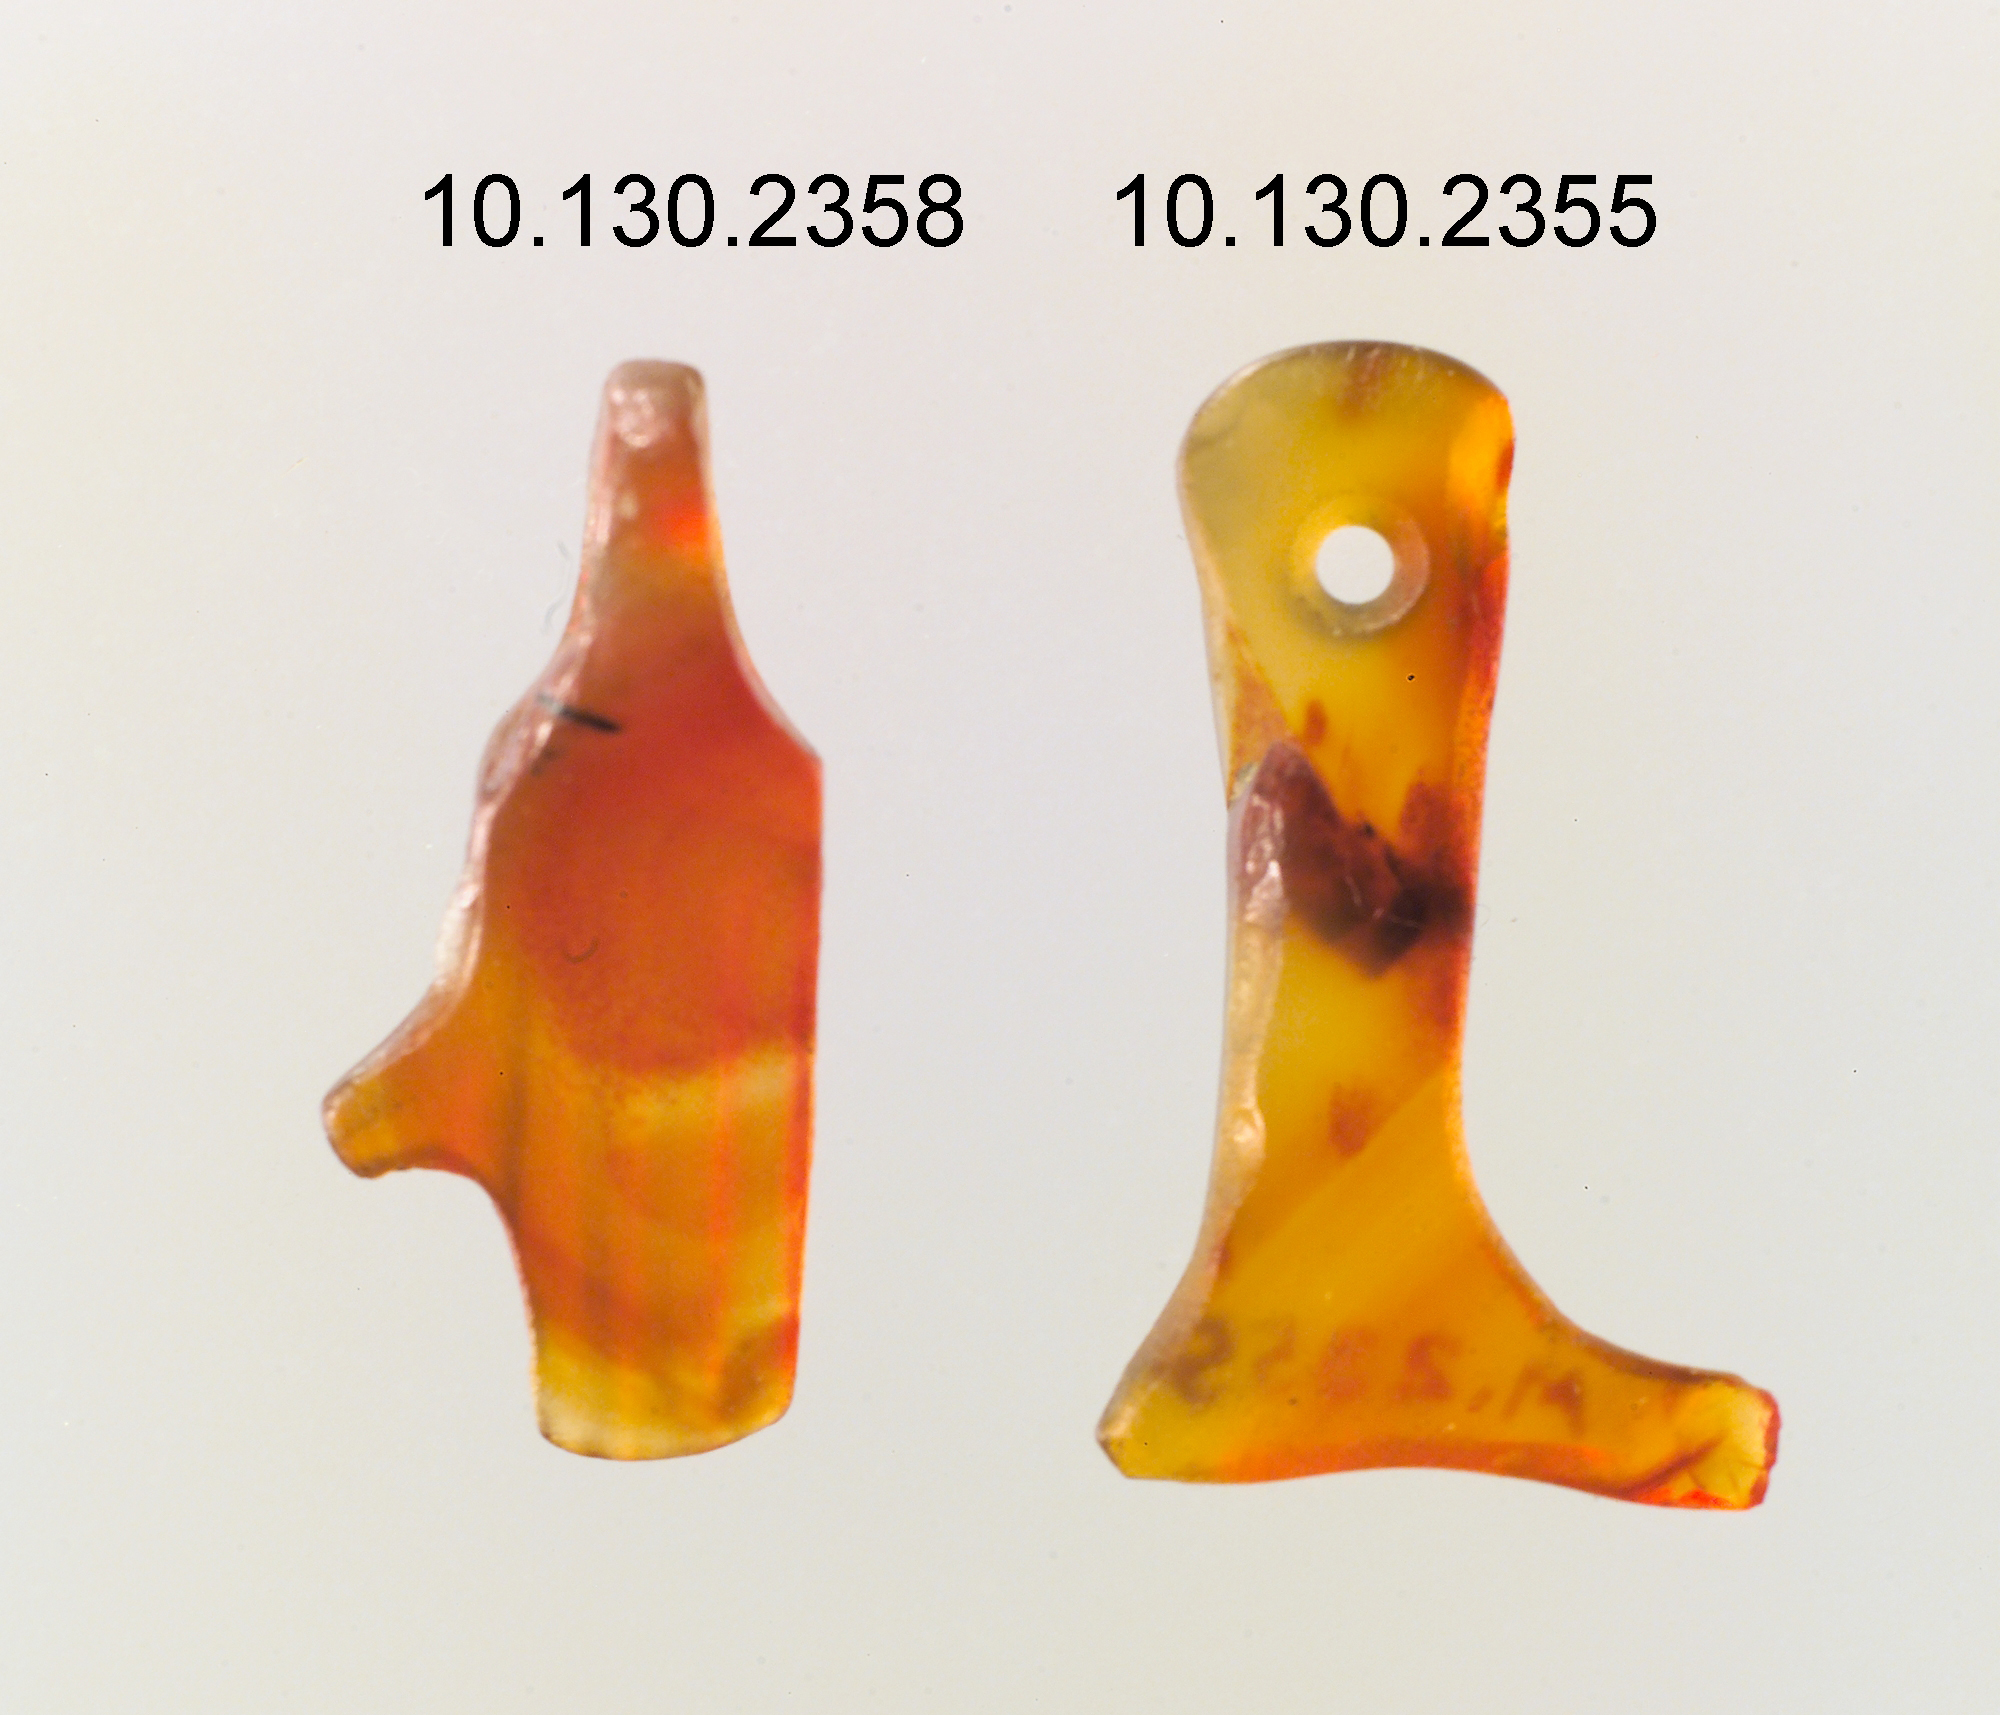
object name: amulet, hand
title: Hand Amulet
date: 2465-2100 BCE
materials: gemstone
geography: egypt